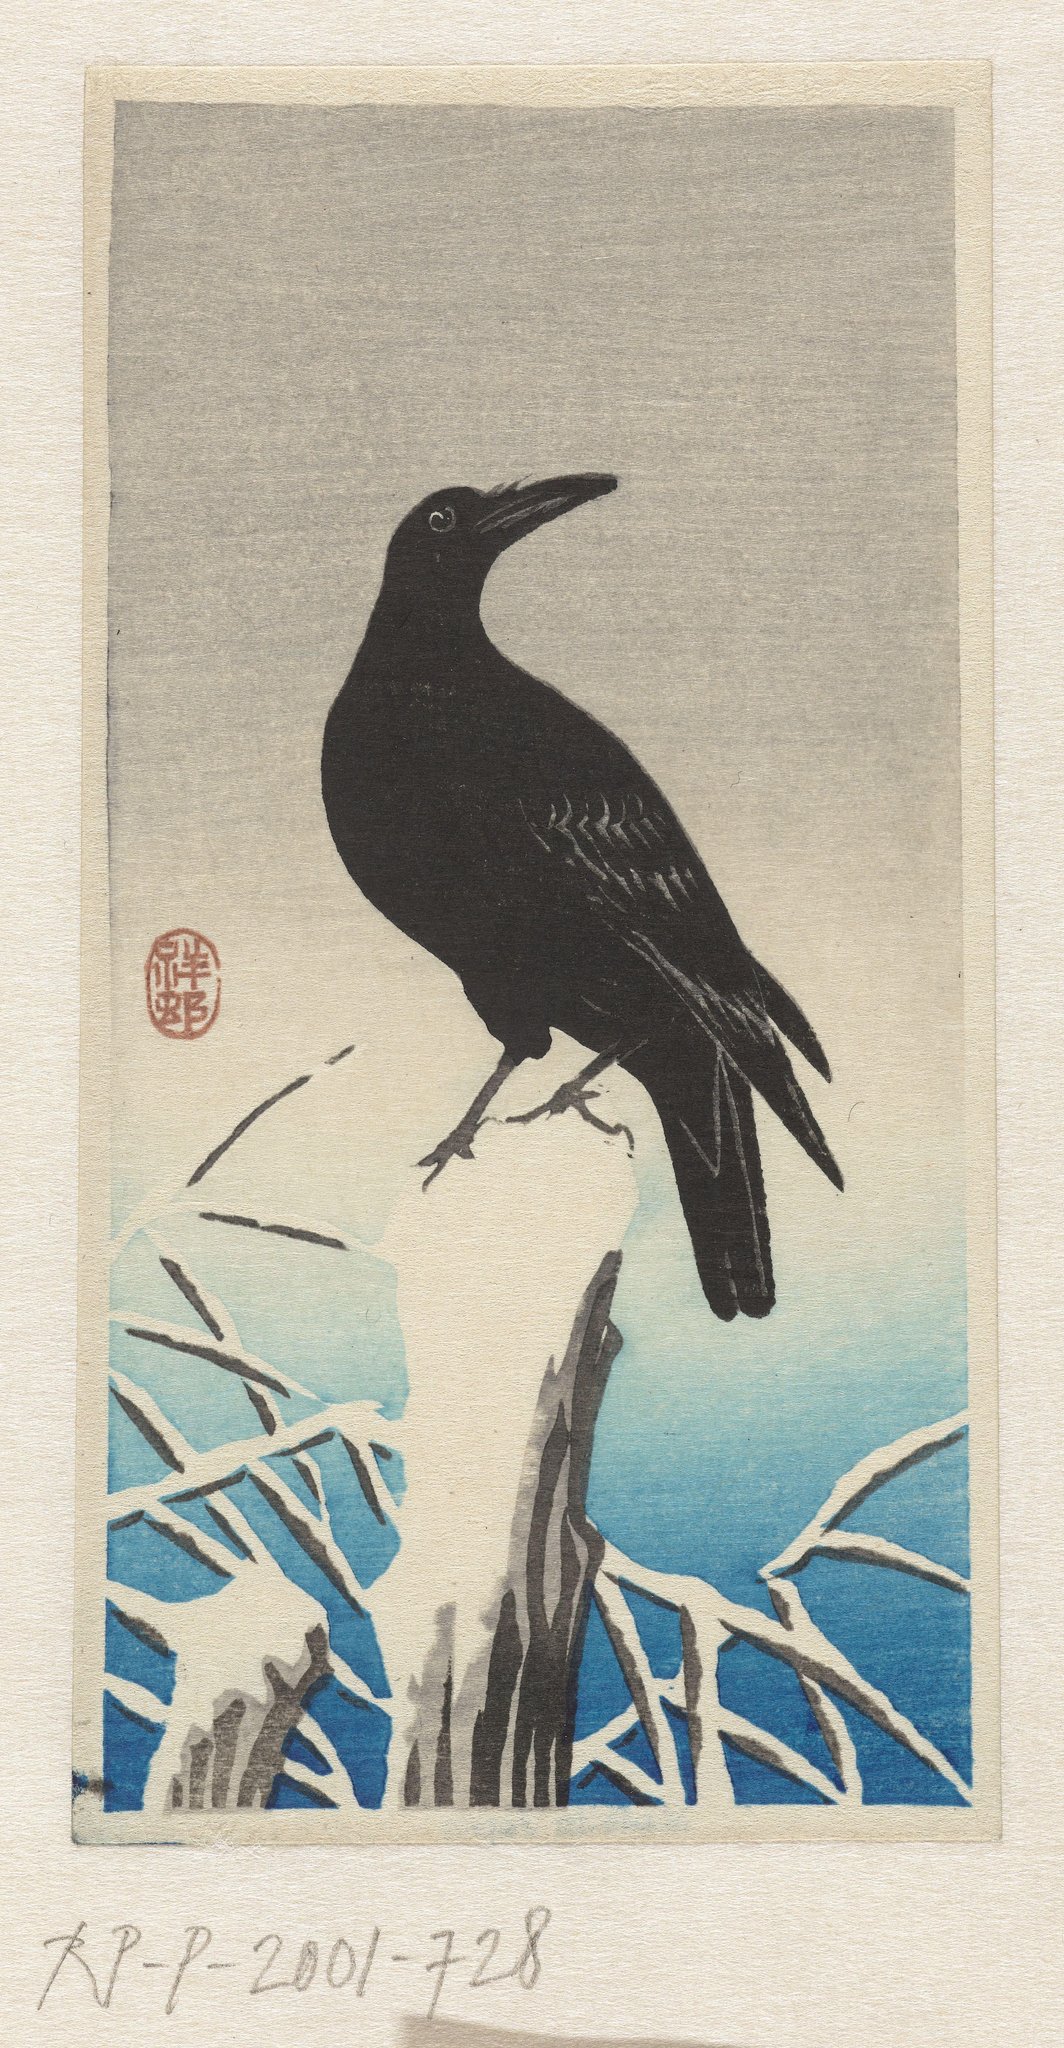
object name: print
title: Crow on snow-covered tree stump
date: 1925-1936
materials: paper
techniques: woodcut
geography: tokyo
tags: birds, plants and herbs: reed, snow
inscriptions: collector's mark: Lugt 2228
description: Kraai, naar rechts, op besneeuwde paal, bij riet.